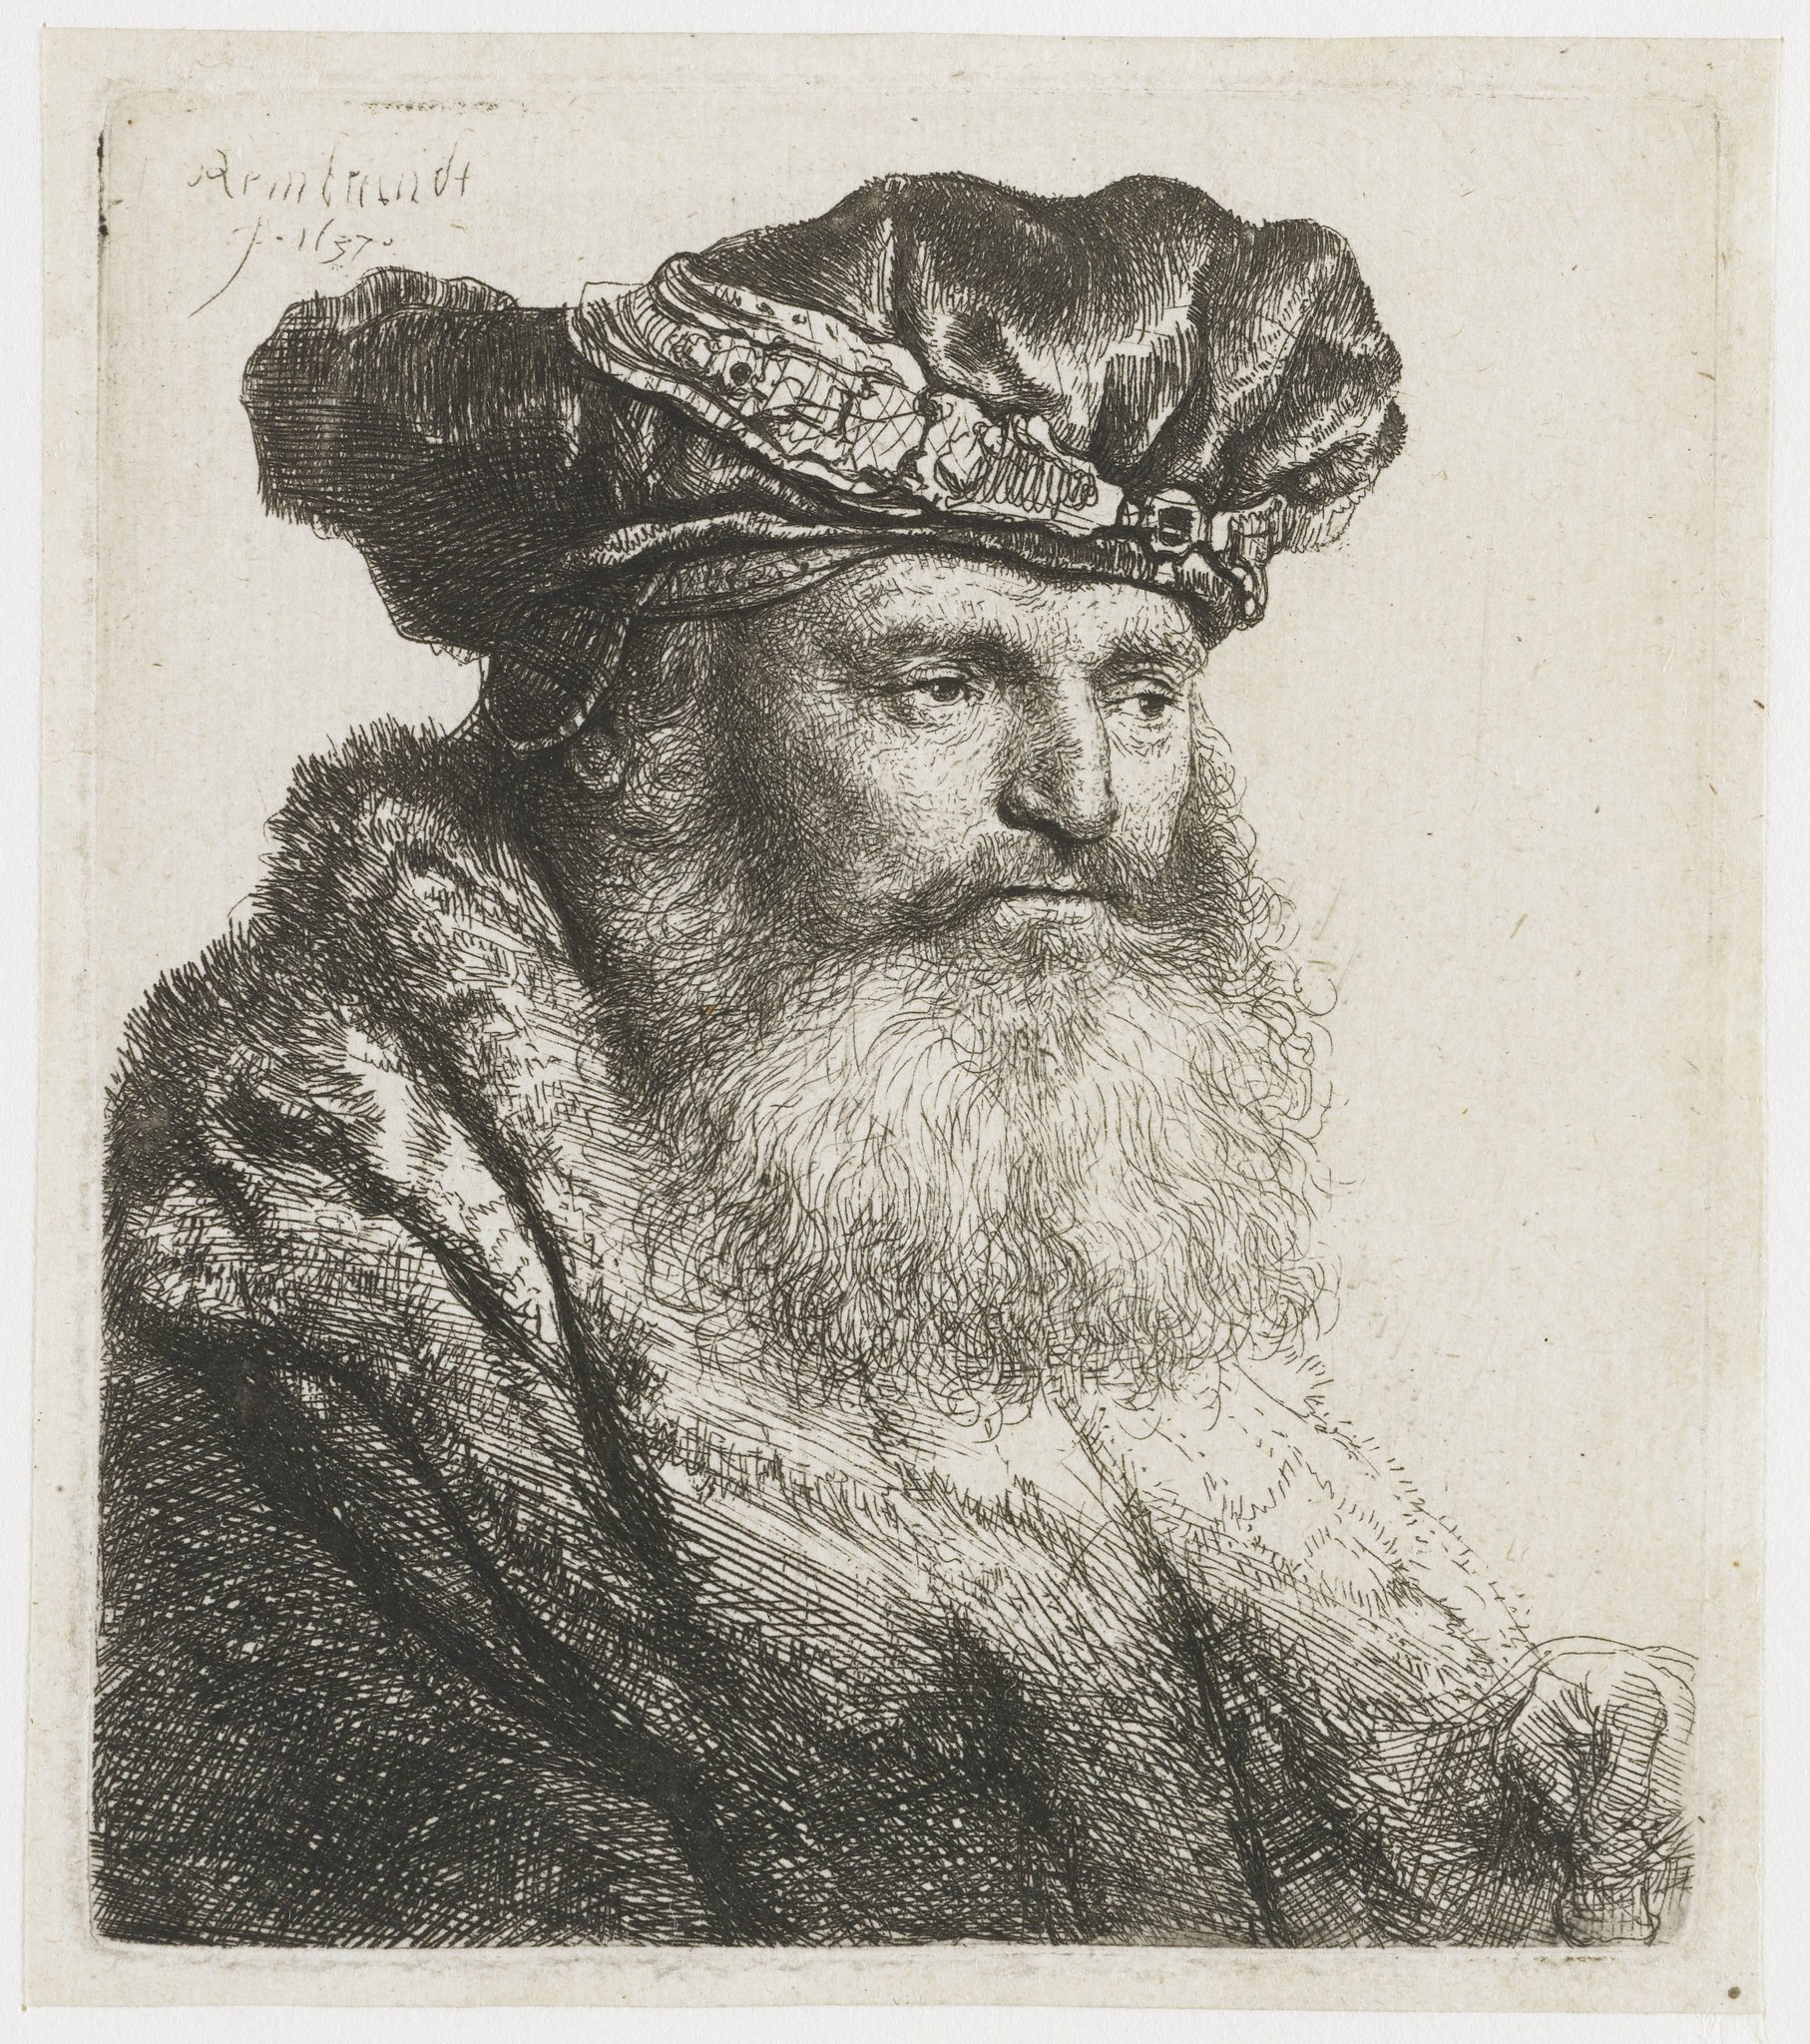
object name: print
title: Bearded Man in a Velvet Cap with a Jewelled Clasp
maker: rembrandt van rijn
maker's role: draughtsman, painter, print maker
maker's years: 1606-1669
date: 1637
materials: paper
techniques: etching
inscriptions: signature and date: ‘Rembrandt f 1637’, mark: Lugt 2228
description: The attire of these men leaves no doubt that they were intended as tronies. They wear berets, one of which is decorated with a cloak clasp, or a Polish fur cap (kutchma). In the print with the fur cap, the clasp simply adorns the man’s chest. The faces are sometimes so specifically rendered that they strike one as being portraits.